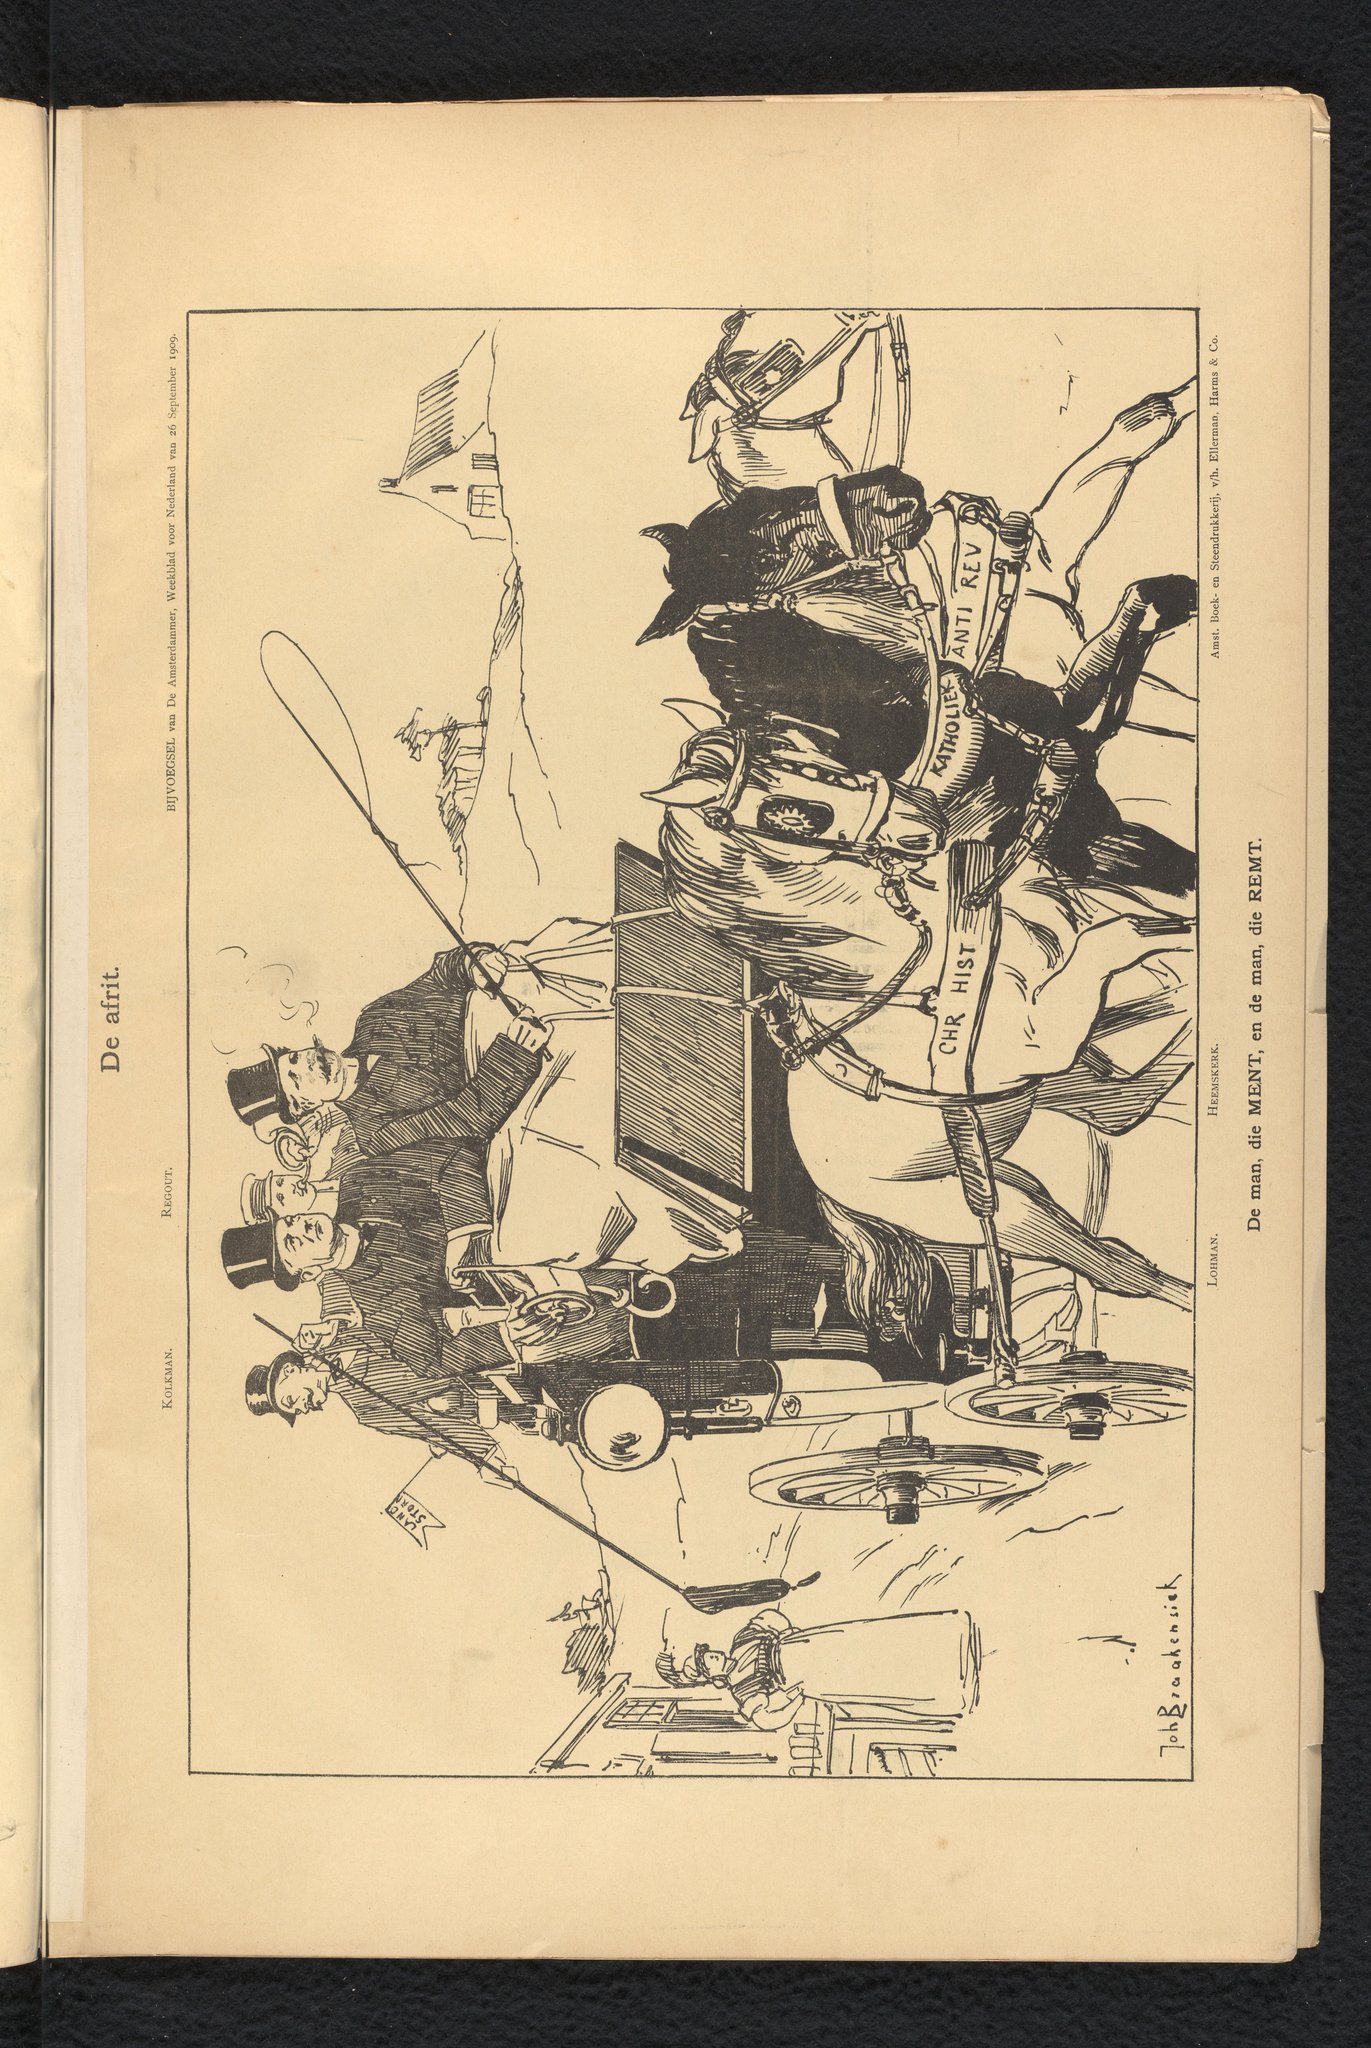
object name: cartoon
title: De afrit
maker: johan braakensiek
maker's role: draughtsman, print maker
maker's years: 1858-1940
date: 1909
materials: paper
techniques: lithograph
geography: netherlands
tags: jonkheer alexander frederik de savornin lohman, amsterdam, utrecht, maastricht, dordrecht, the hague, politician, four-wheeled vehicle drawn by three animals, political parties, political caricatures and satires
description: Koets getrokken door de drie paarden van de politieke partijen Christelijk Historisch, Katholieken en Antirevolutionairen. Op de wagen Heemskerk als koetsier met Lohman naast hem die remt. Achter hen collecteert Kolkman in het voorbijgaan bij de Nederlandse maagd en Regout blaast op de posthoorn.